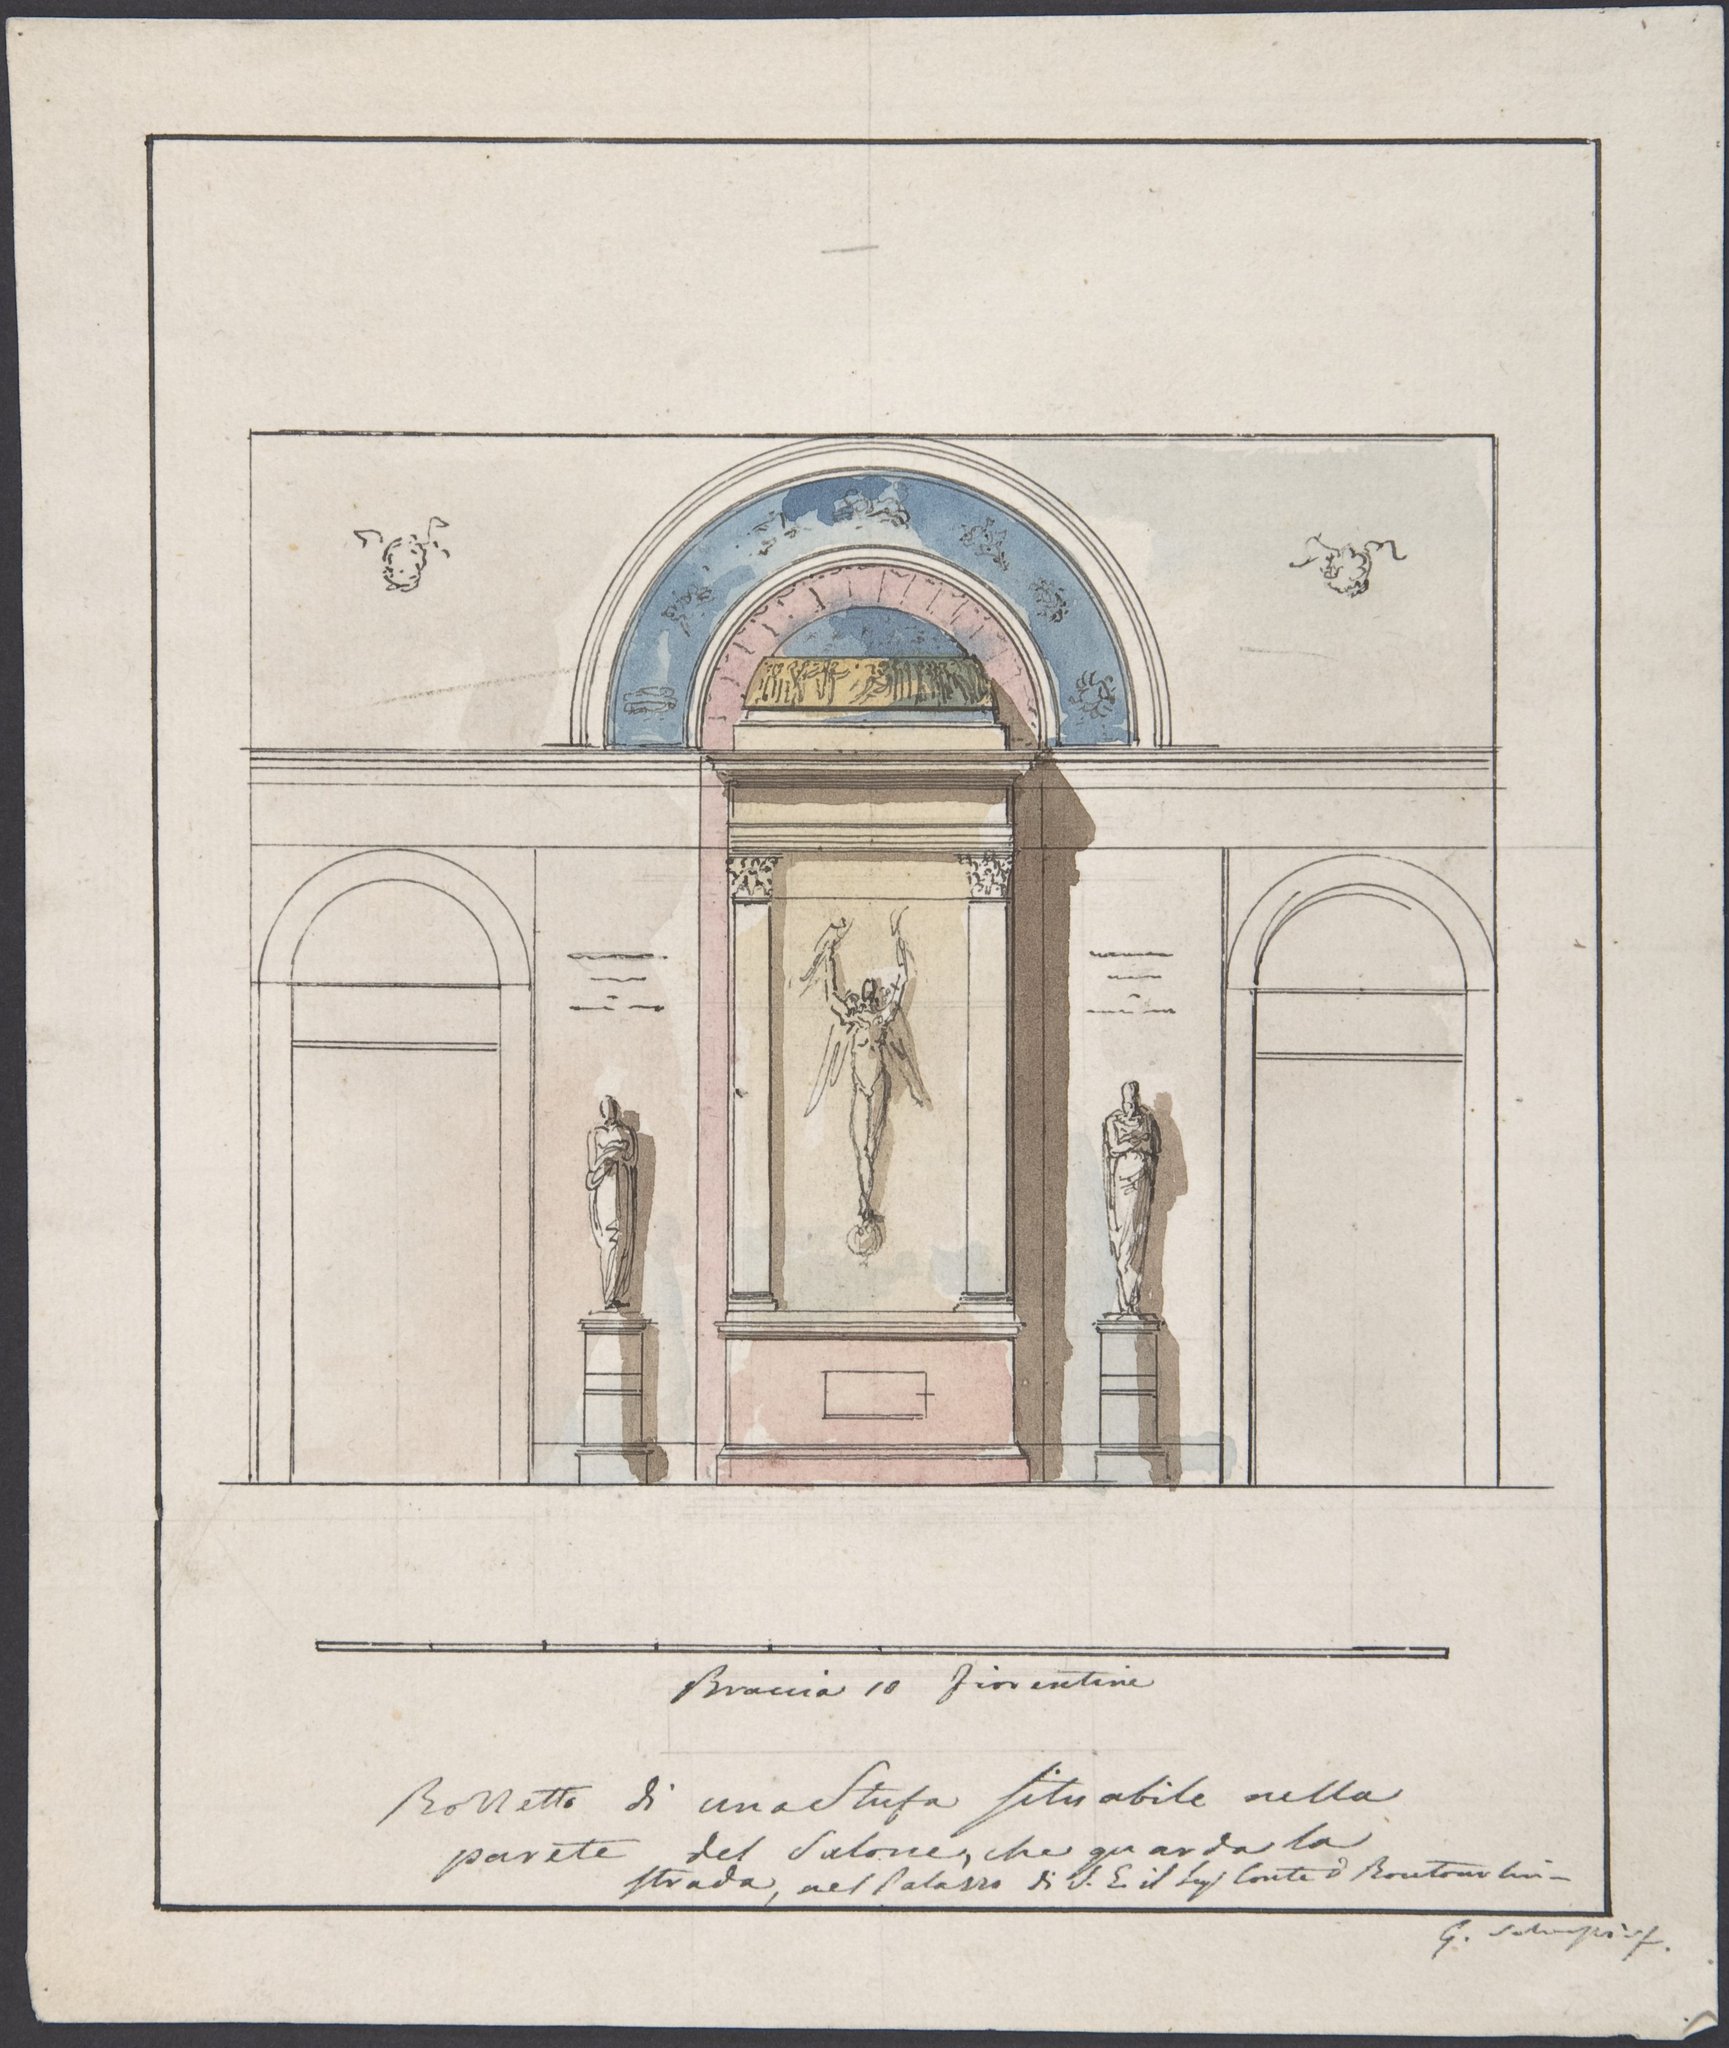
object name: drawing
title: Elevation "della nuova Galleria"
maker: giovanni battista silvestri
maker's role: artist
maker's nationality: italian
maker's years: 1796-1873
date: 1796-1873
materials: ink, paper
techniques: pen, wash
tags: architecture